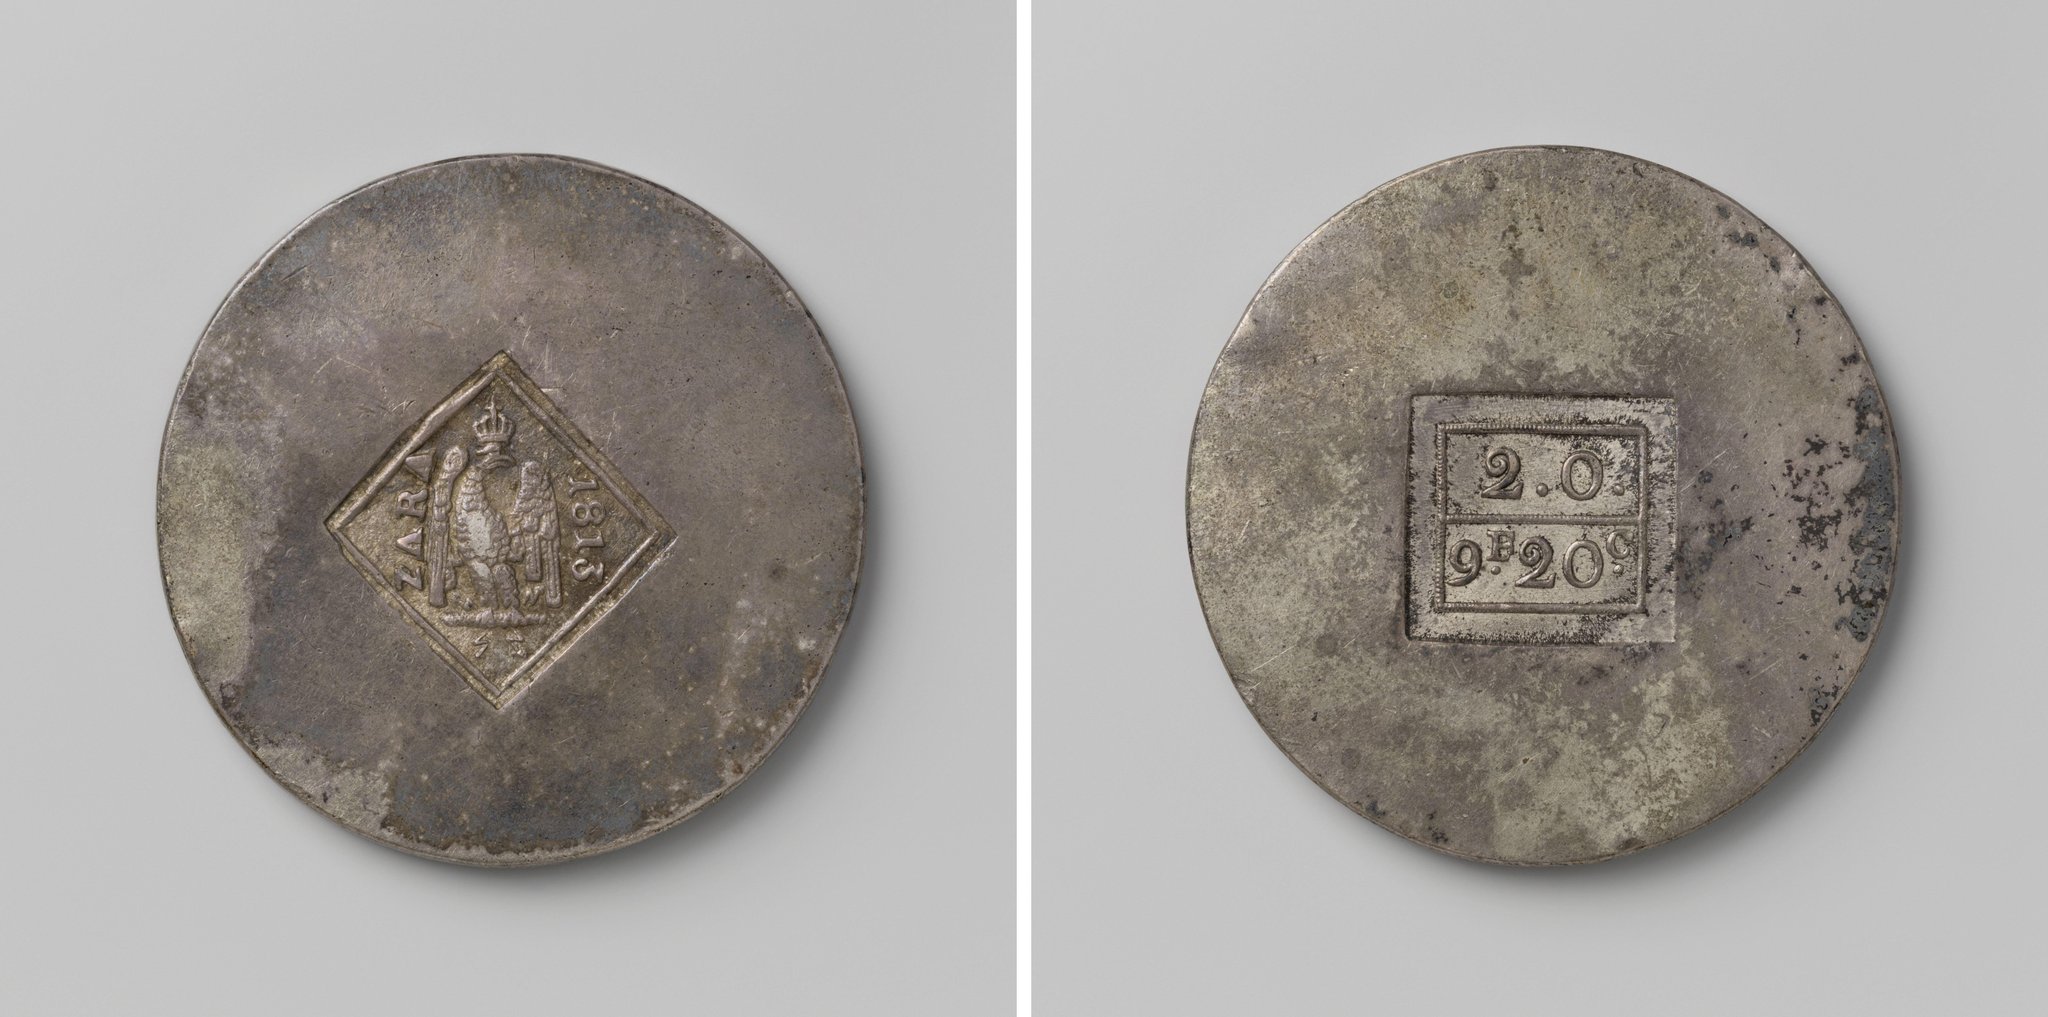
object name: coin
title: Negen francs twintig centimes, noodmunt uit Zara, geslagen tijdens het beleg door de Oostenrijkers, door de Fransen, op een gewicht van twee ons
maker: Anonymous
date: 1813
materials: silver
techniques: striking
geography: zara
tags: zara, beleg van zara